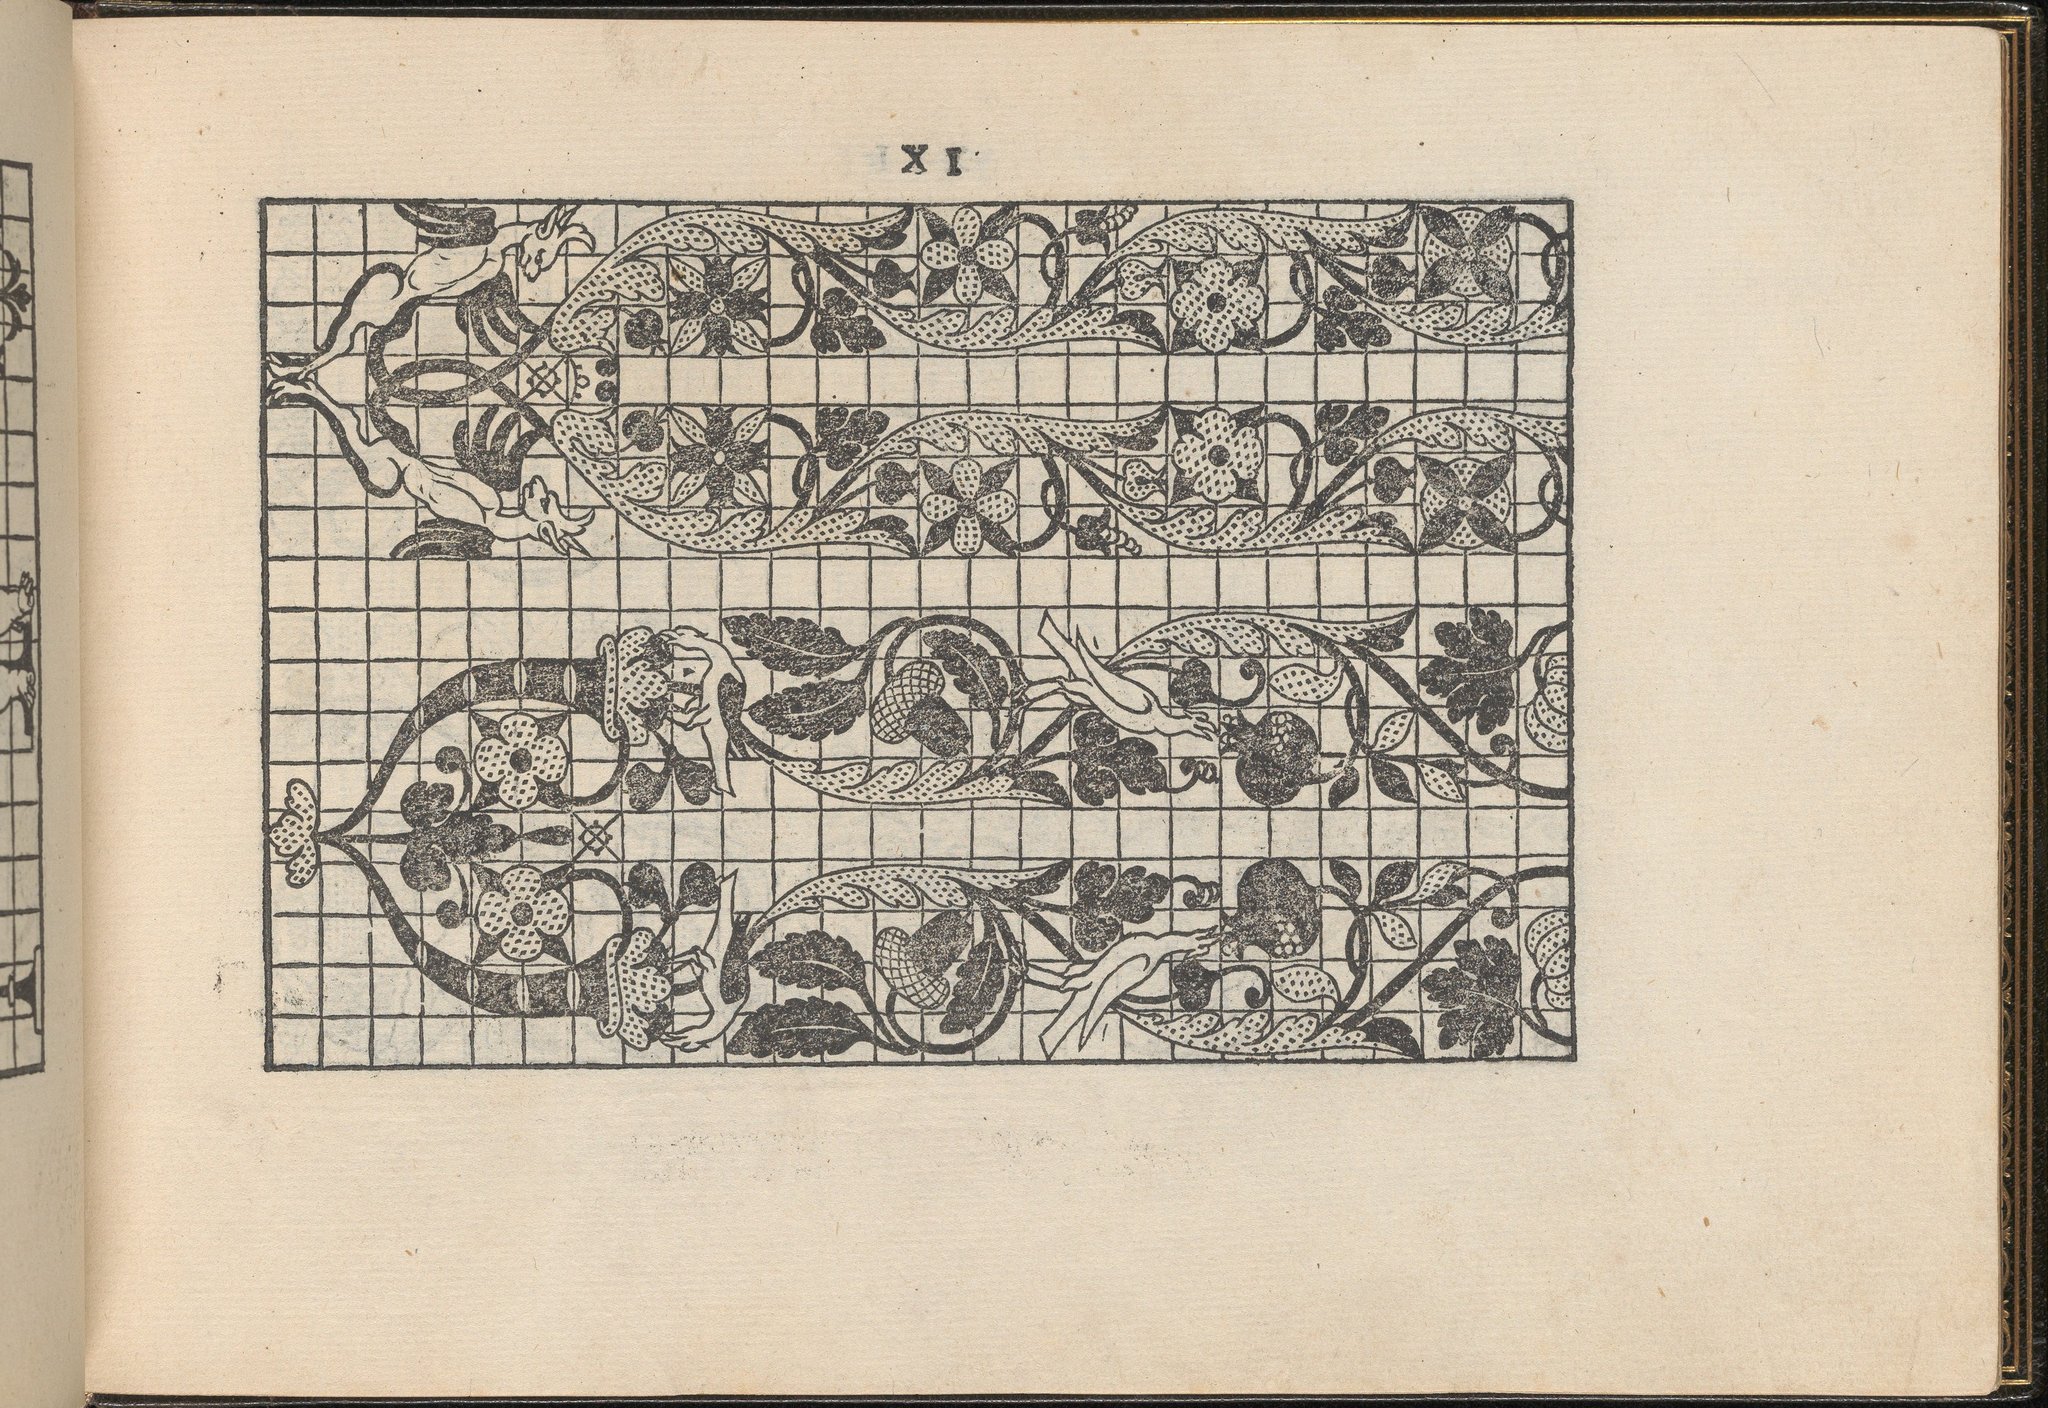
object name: book print ornament architecture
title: La Vera Perfettione del Disegno di varie sorti di recami, page 6 (recto)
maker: giovanni ostaus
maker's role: publisher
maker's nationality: italian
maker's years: 1507-1607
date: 1567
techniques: woodcut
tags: birds,fruit,flowers